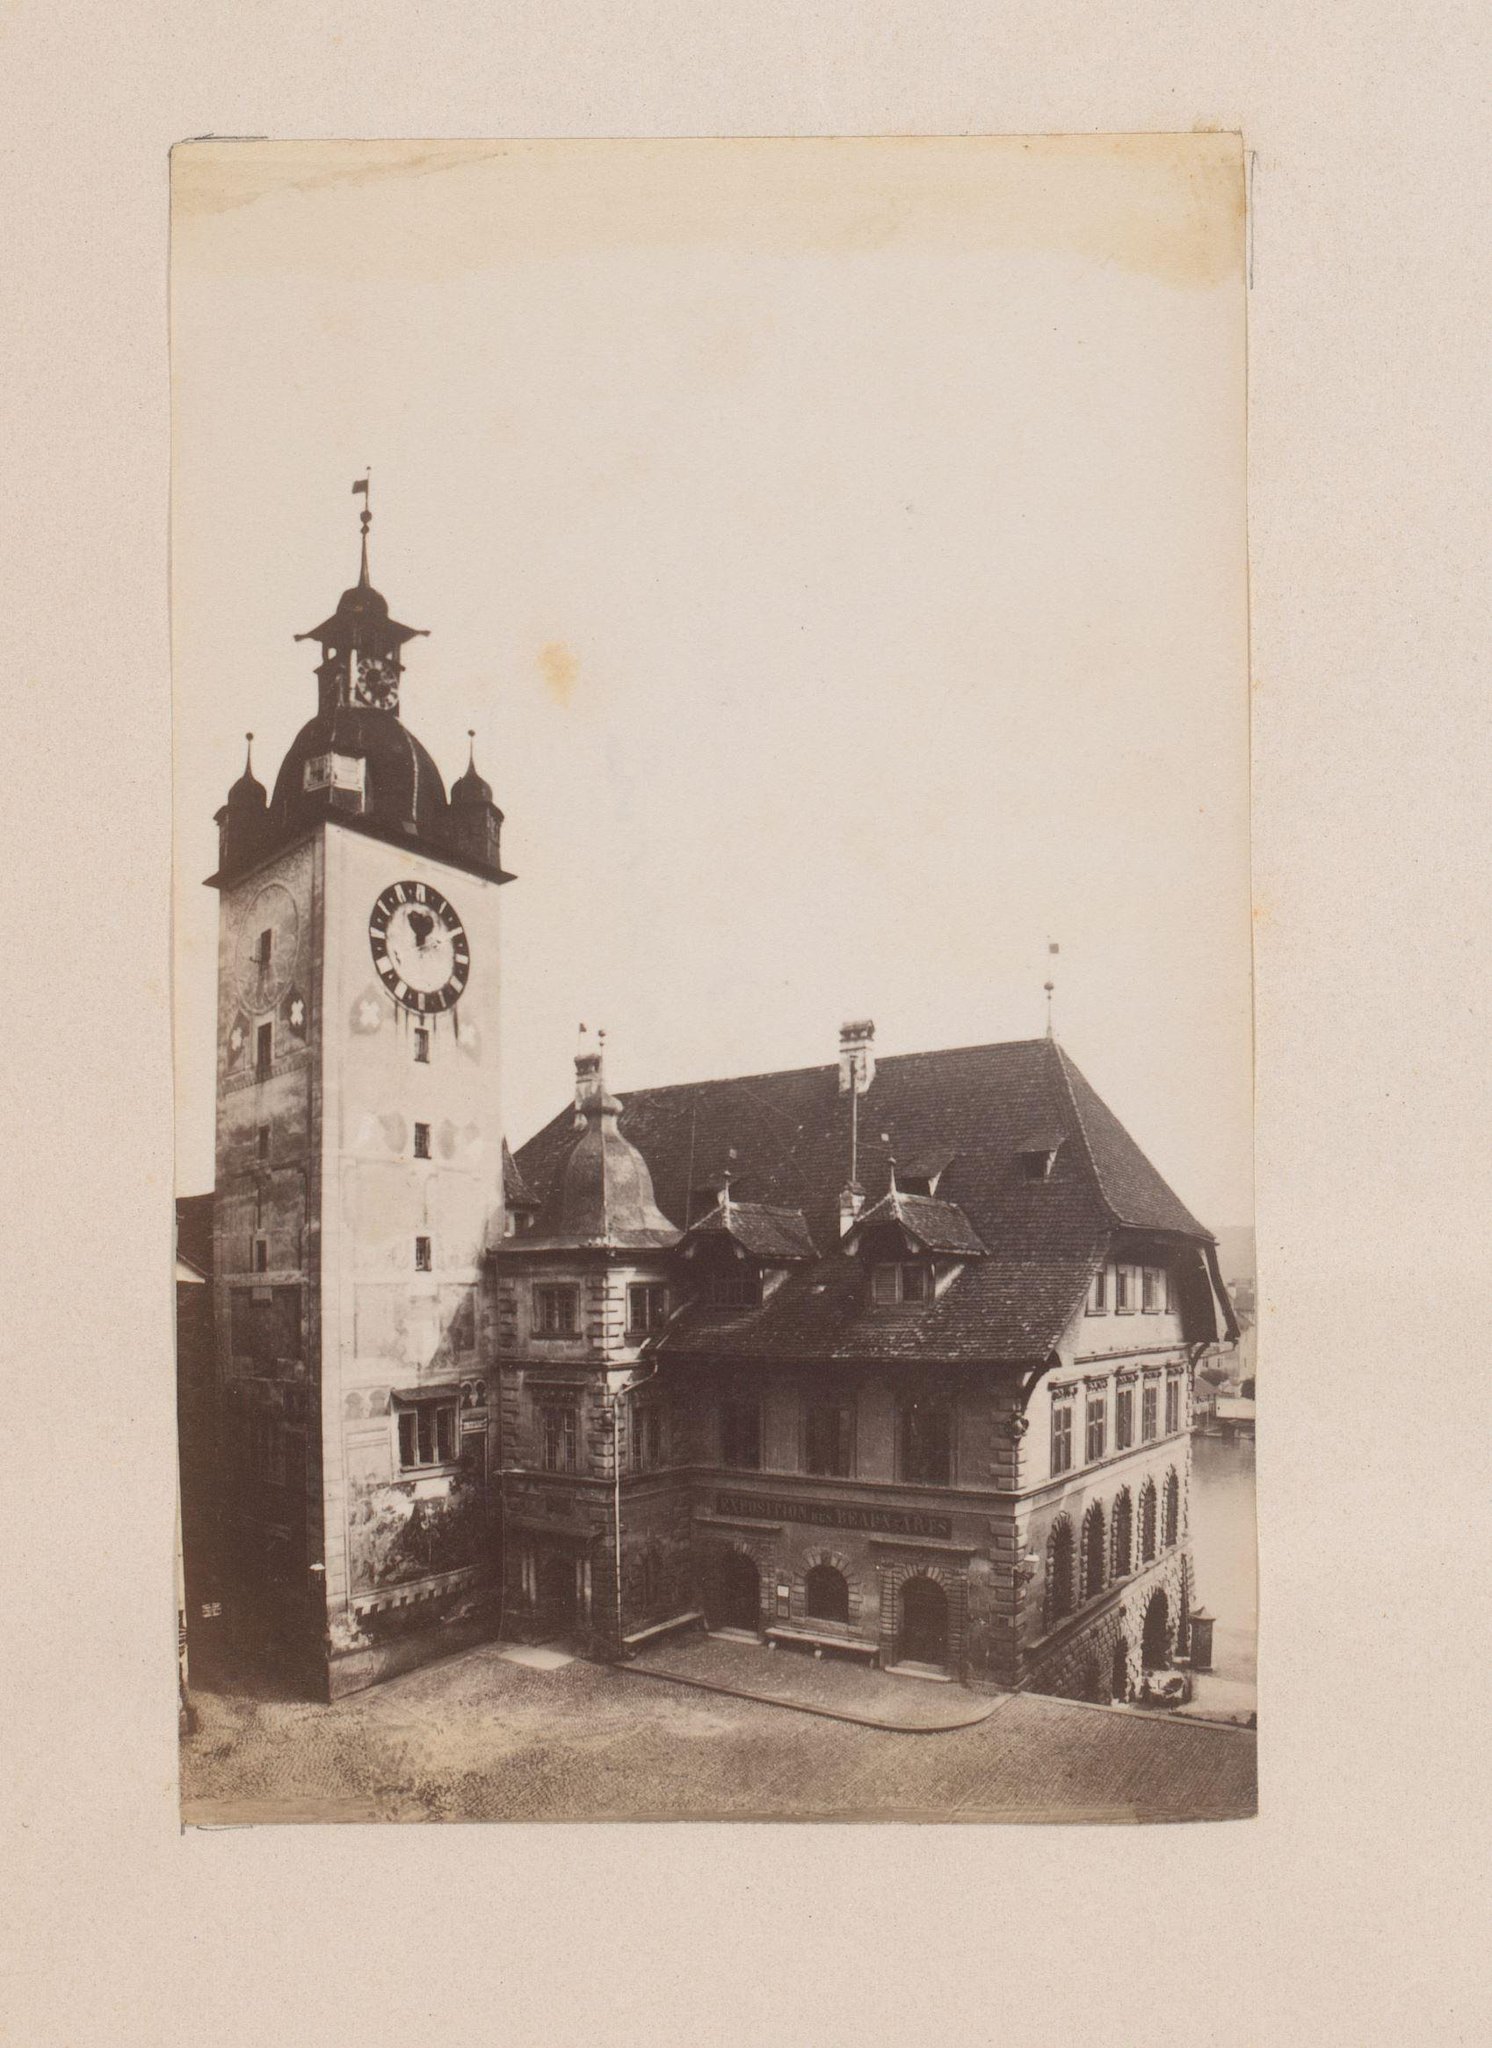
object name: photograph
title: Toren met klokken in een stad, Bazel [?], Zwitserland [?]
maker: Anonymous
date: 1880-1910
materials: paper, photographic support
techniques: albumen print